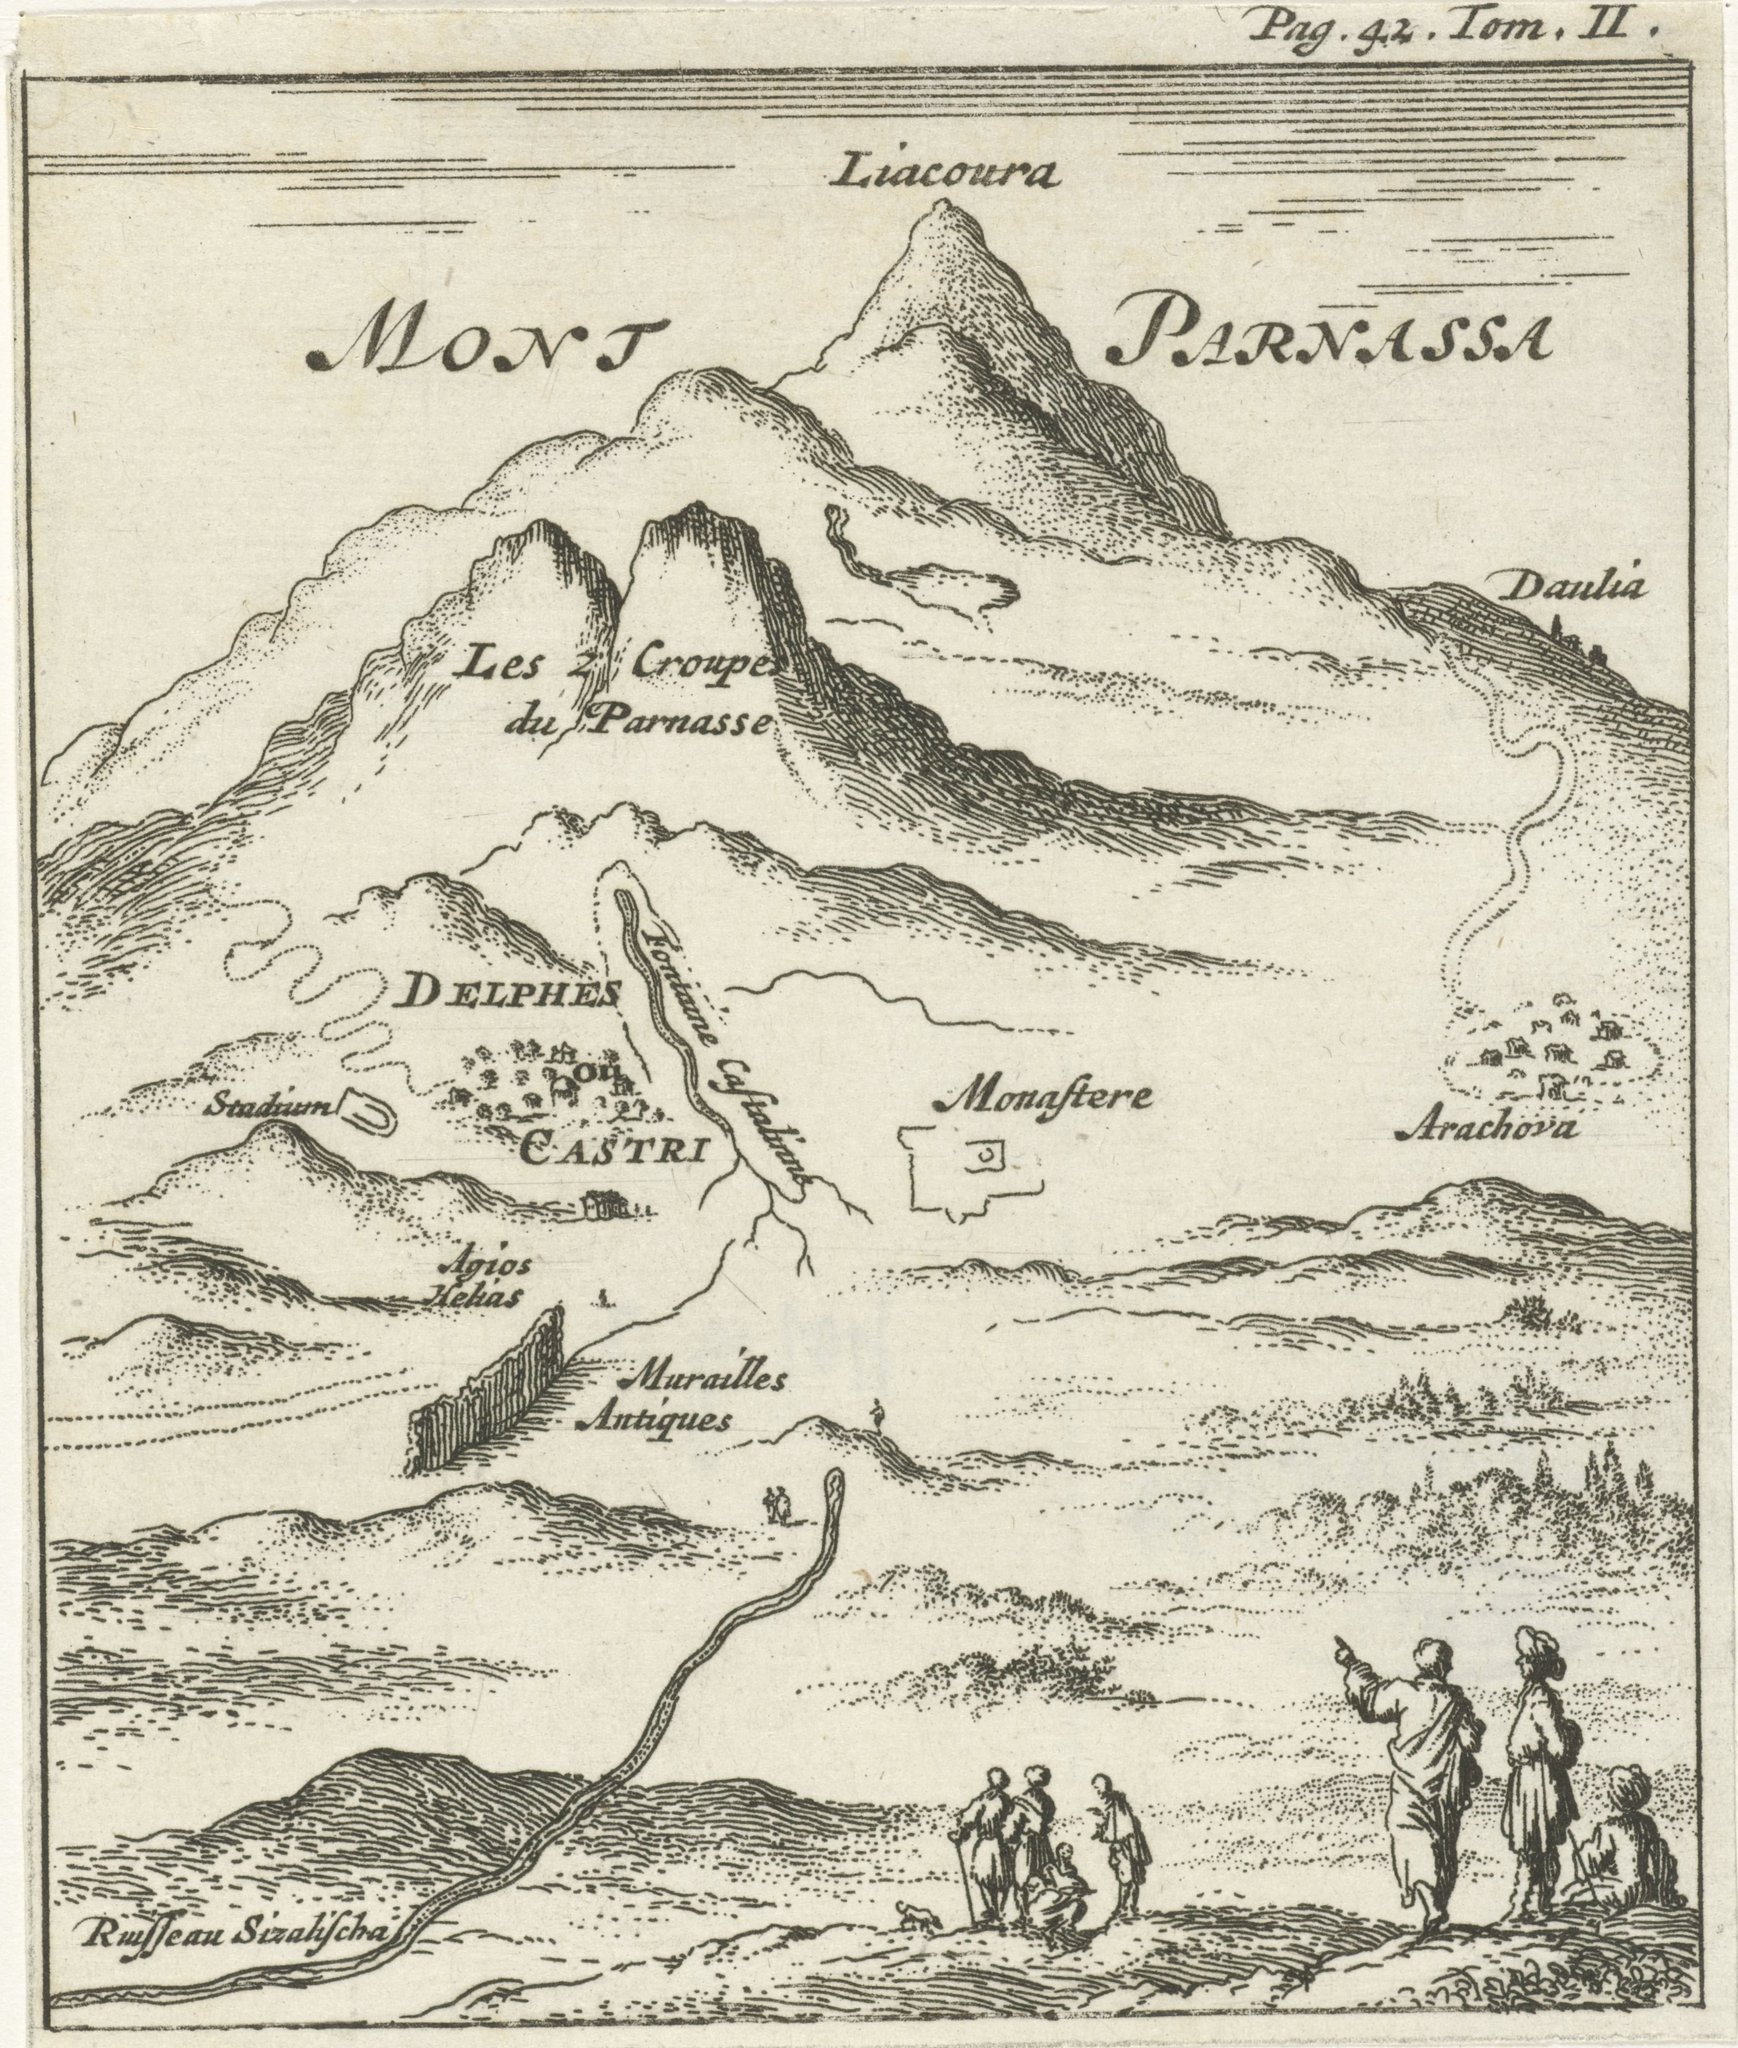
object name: book illustration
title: Mont Parnassa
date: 1679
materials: paper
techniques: etching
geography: amsterdam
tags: mountains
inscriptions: collector's mark: Lugt 2228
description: Illustratie opgenomen in: Spon, Jacob. Voyage d'Italie, de Dalmatie, de Grece, et du Levant, 2 delen, dl. II, p. 42. Amsterdam: Hendrick en Dirk Boom, 1679.